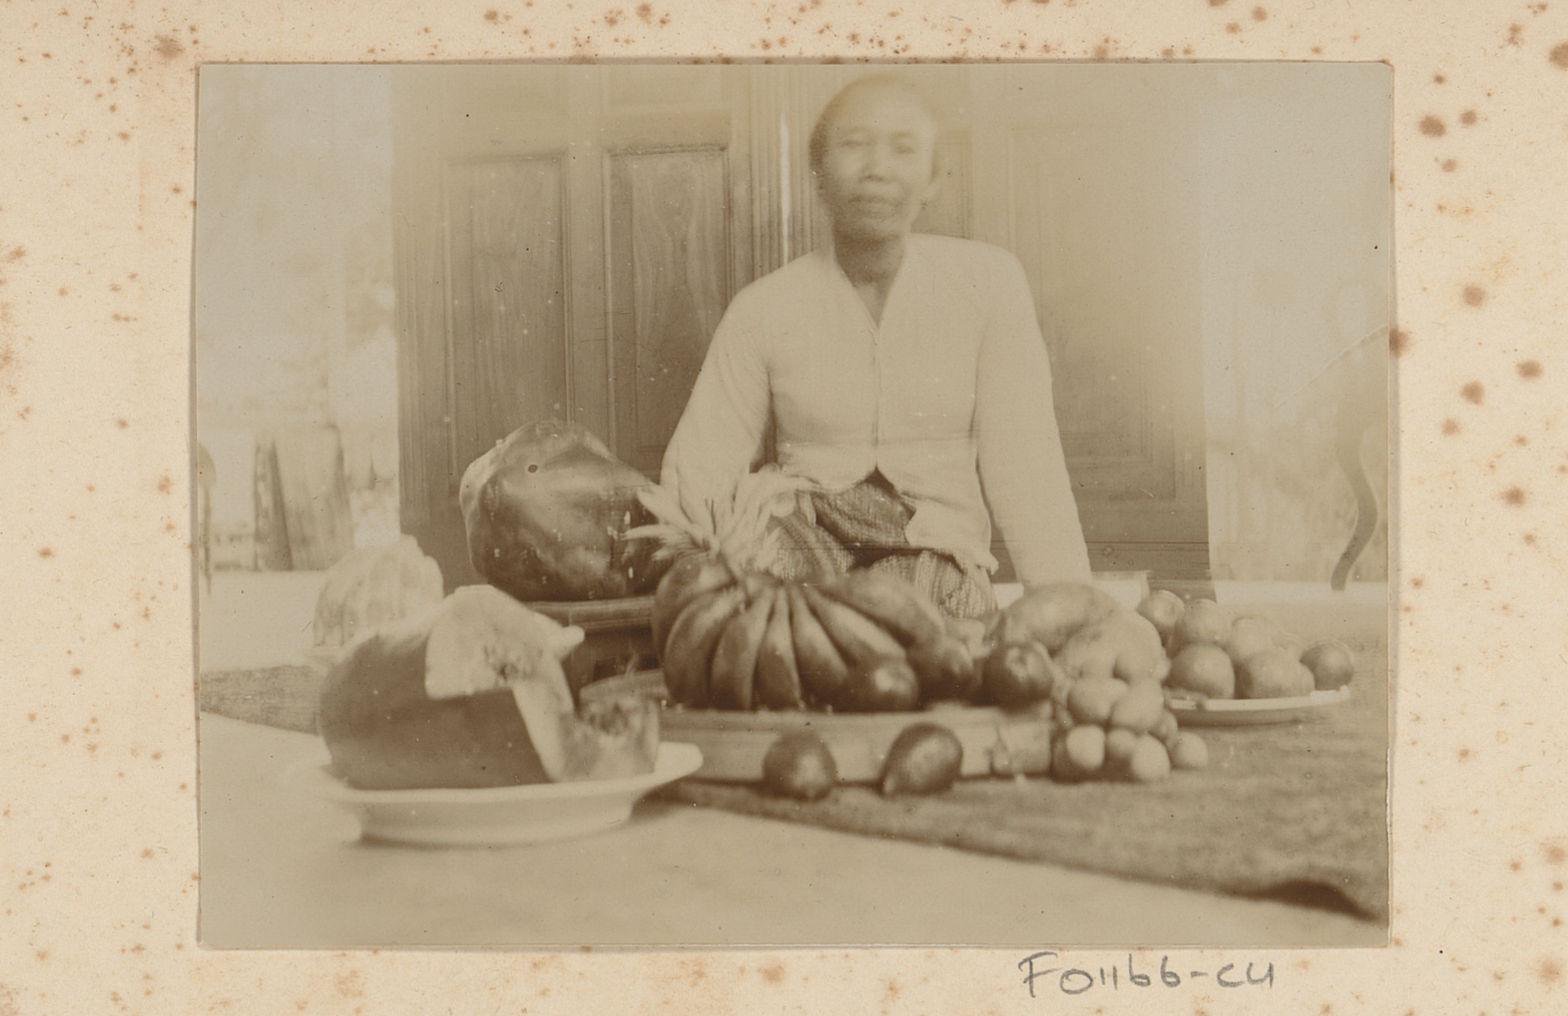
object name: album leaf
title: Nederlands-Indië, fruitstilleven op vloer met Indonesische vrouw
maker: Anonymous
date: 1880-1910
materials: photographic support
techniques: gelatin silver print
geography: dutch east indies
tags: adult woman, historical persons, fruits, dutch east indies, the